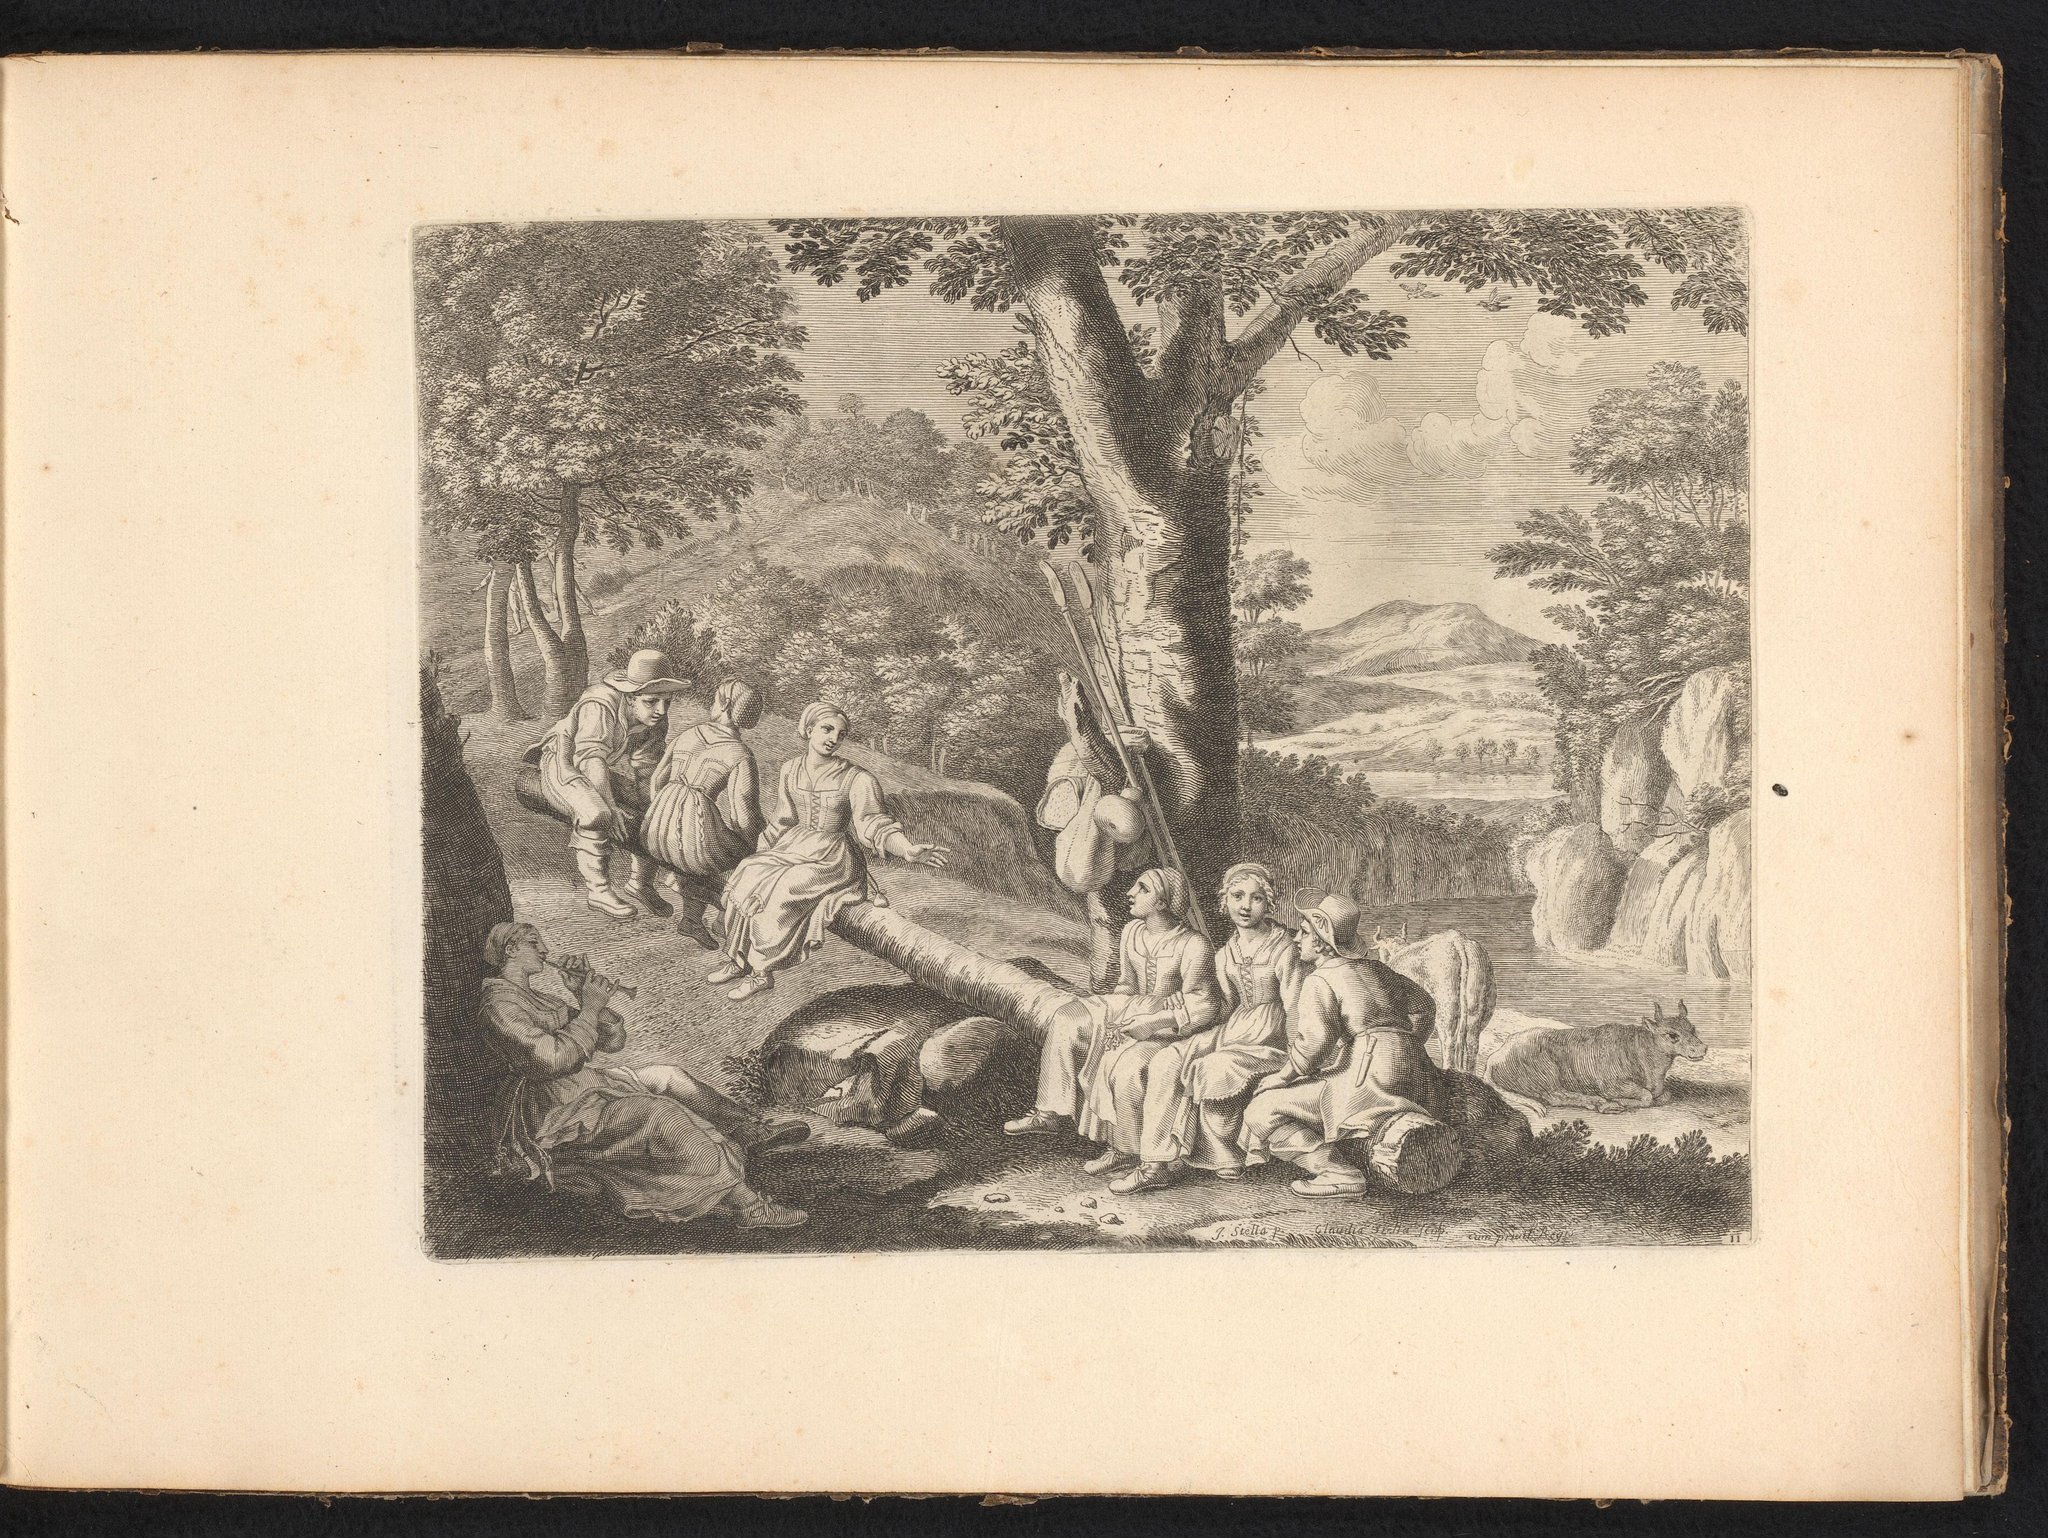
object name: album leaf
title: Rustende herders spelend op een wip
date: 1667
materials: paper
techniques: engraving, etching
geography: paris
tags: landscapes, herding, herdsman, herdswoman, shepherd, shepherdess, cowherd, etc., seesaw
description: Landschap met een groep herders op een boomstam die ze als wip gebruiken. Ernaast een fluitspelende vrouw. Prent maakt deel uit van een album.